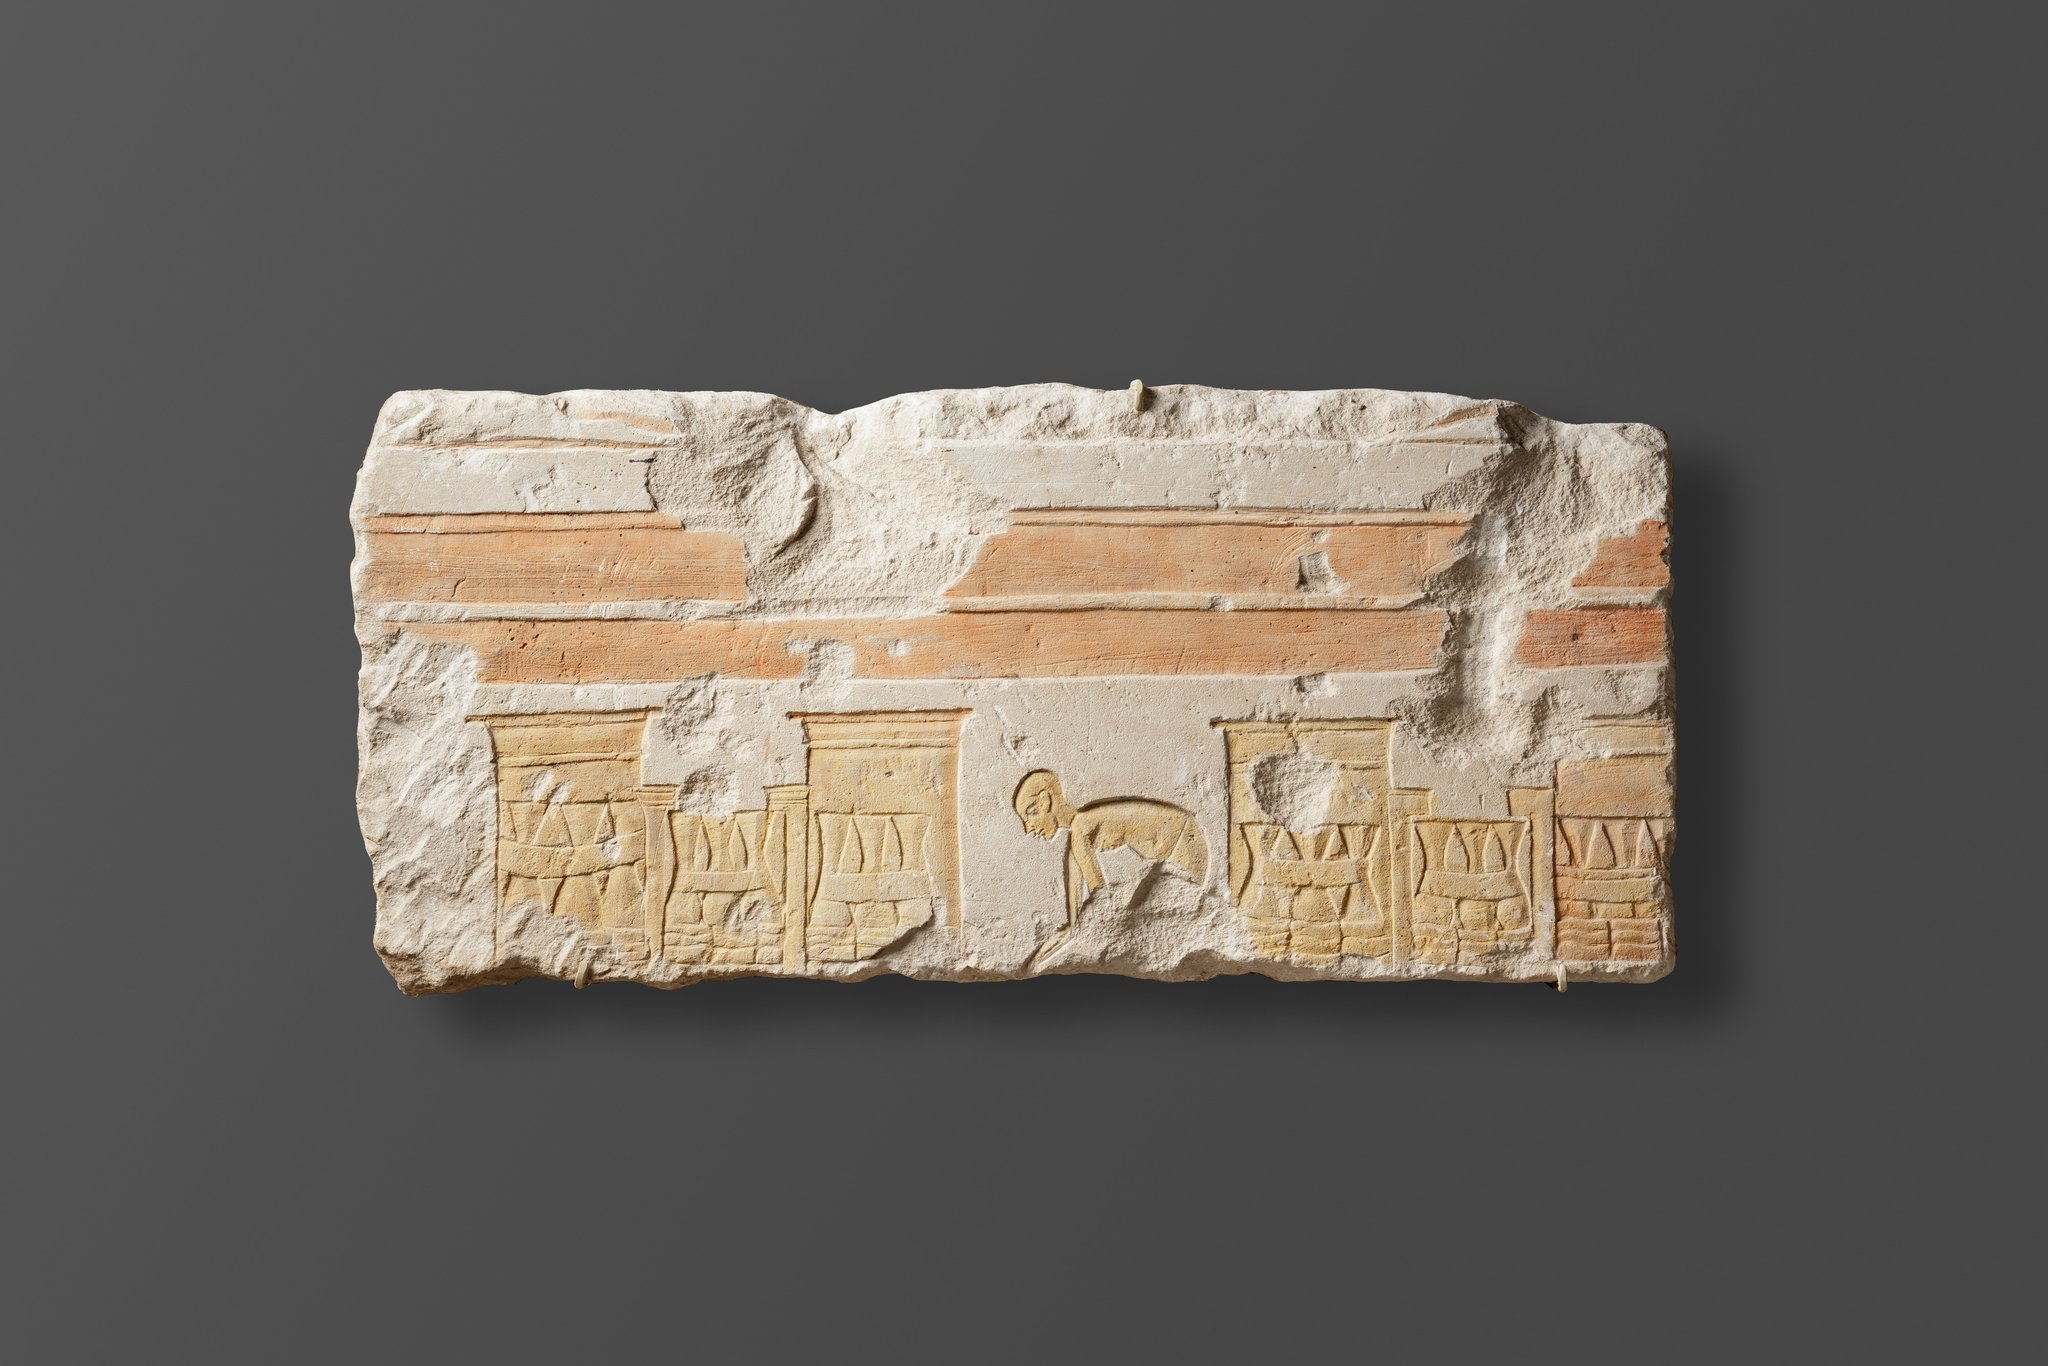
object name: talatat, temple courtyard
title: Relief fragment with a temple courtyard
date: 1353-1336 BCE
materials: limestone, paint